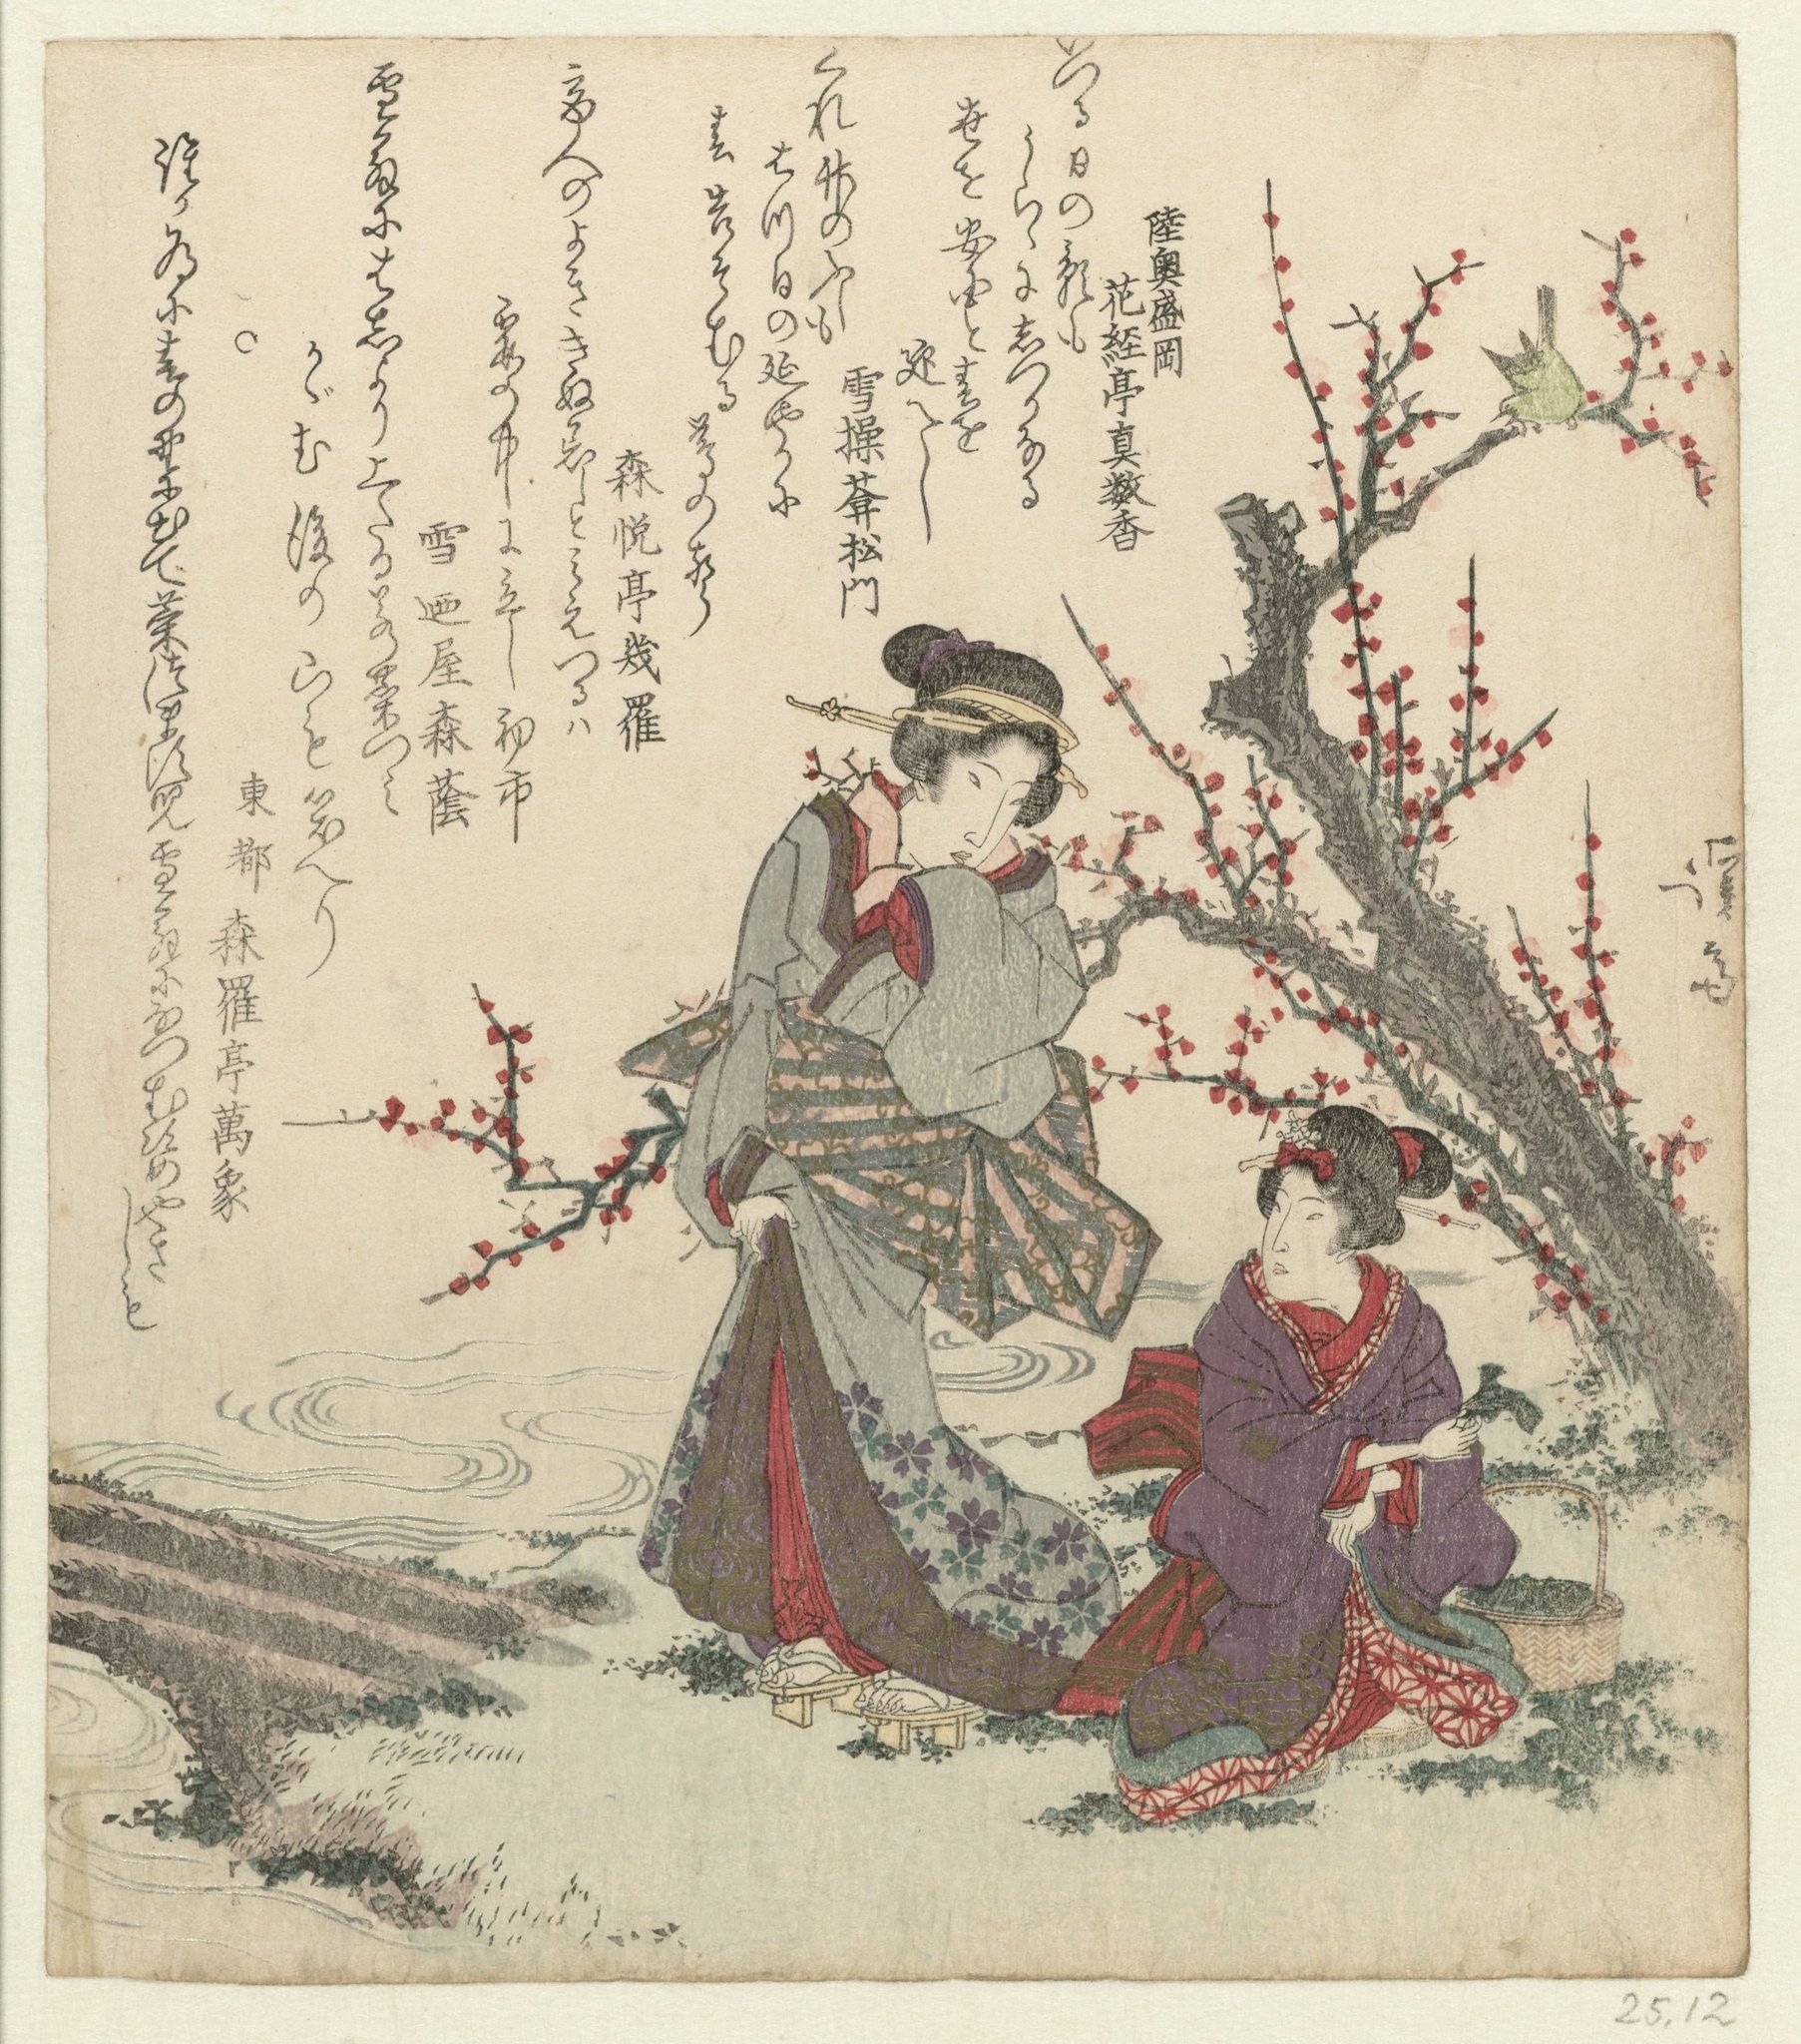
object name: surimono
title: Twee vrouwen op zoek naar kruiden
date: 1830-1835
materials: paper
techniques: woodcut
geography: japan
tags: brook, tree: plum-tree, gathering herbs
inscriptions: collector's mark, passe-partout, bottom left, printed: JABdH with a rooster., collector's mark, verso, stamped: Lugt 2228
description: Een surimono is een luxe uitgevoerde prent waarop beeld met één of meerdere gedichten gecombineerd is. Bij het drukken van een surimono werd vaak gebruik gemaakt van dikker papier, blinddruk en metaal pigmenten, zoals koper- en zilverpoeder. De prenten werden vaak in opdracht van dichters gemaakt en als exclusief geschenk aan vrienden en relaties gegeven.